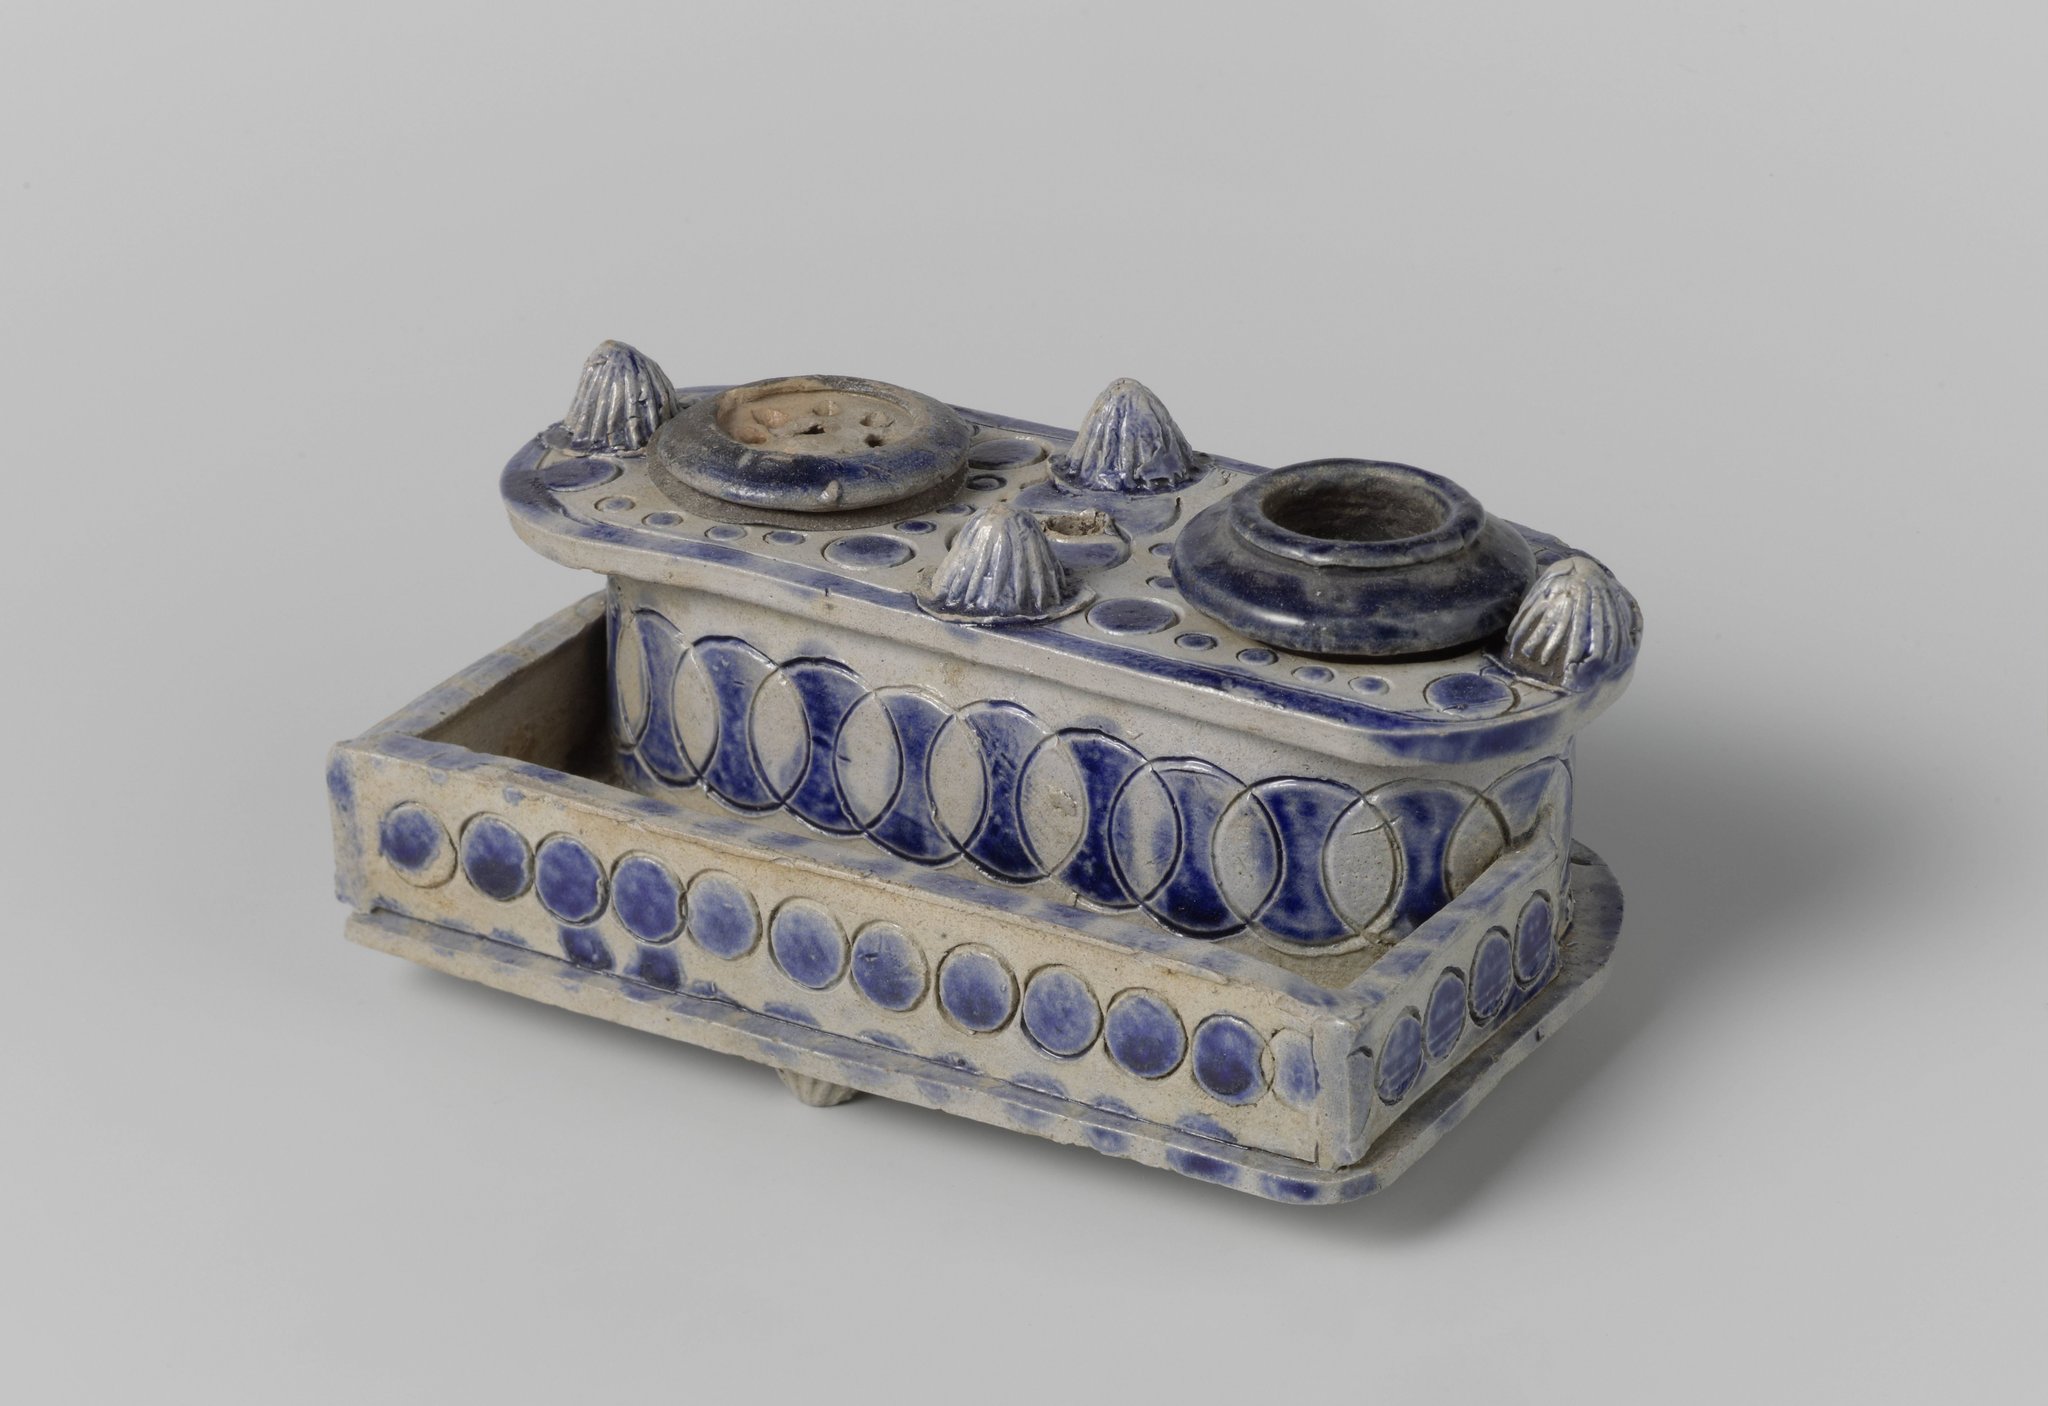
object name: inkstand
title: Ink stand with circles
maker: Anonymous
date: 1750-1799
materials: cobalt, glaze, stoneware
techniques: printing, firing, forming, relief, turning, vitrification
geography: westerwald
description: Inkstel van steengoed op drie lage voeten, met een pennenbak en twee houders voor de inktpot en de zandstrooier. Daarbij zit in één houder een tinnen bakje. Gedeeltelijk bedekt met kobaltblauw. De voor- en achterzijde met een decoratie van gestempelde, aaneengeschakelde cirkels. Op de buitenwand van de pennenbak en op de bovenzijde gestempelde cirkels. Op de bovenzijde viermaal een gemodelleerde 'klinknagel'. Westerwald.